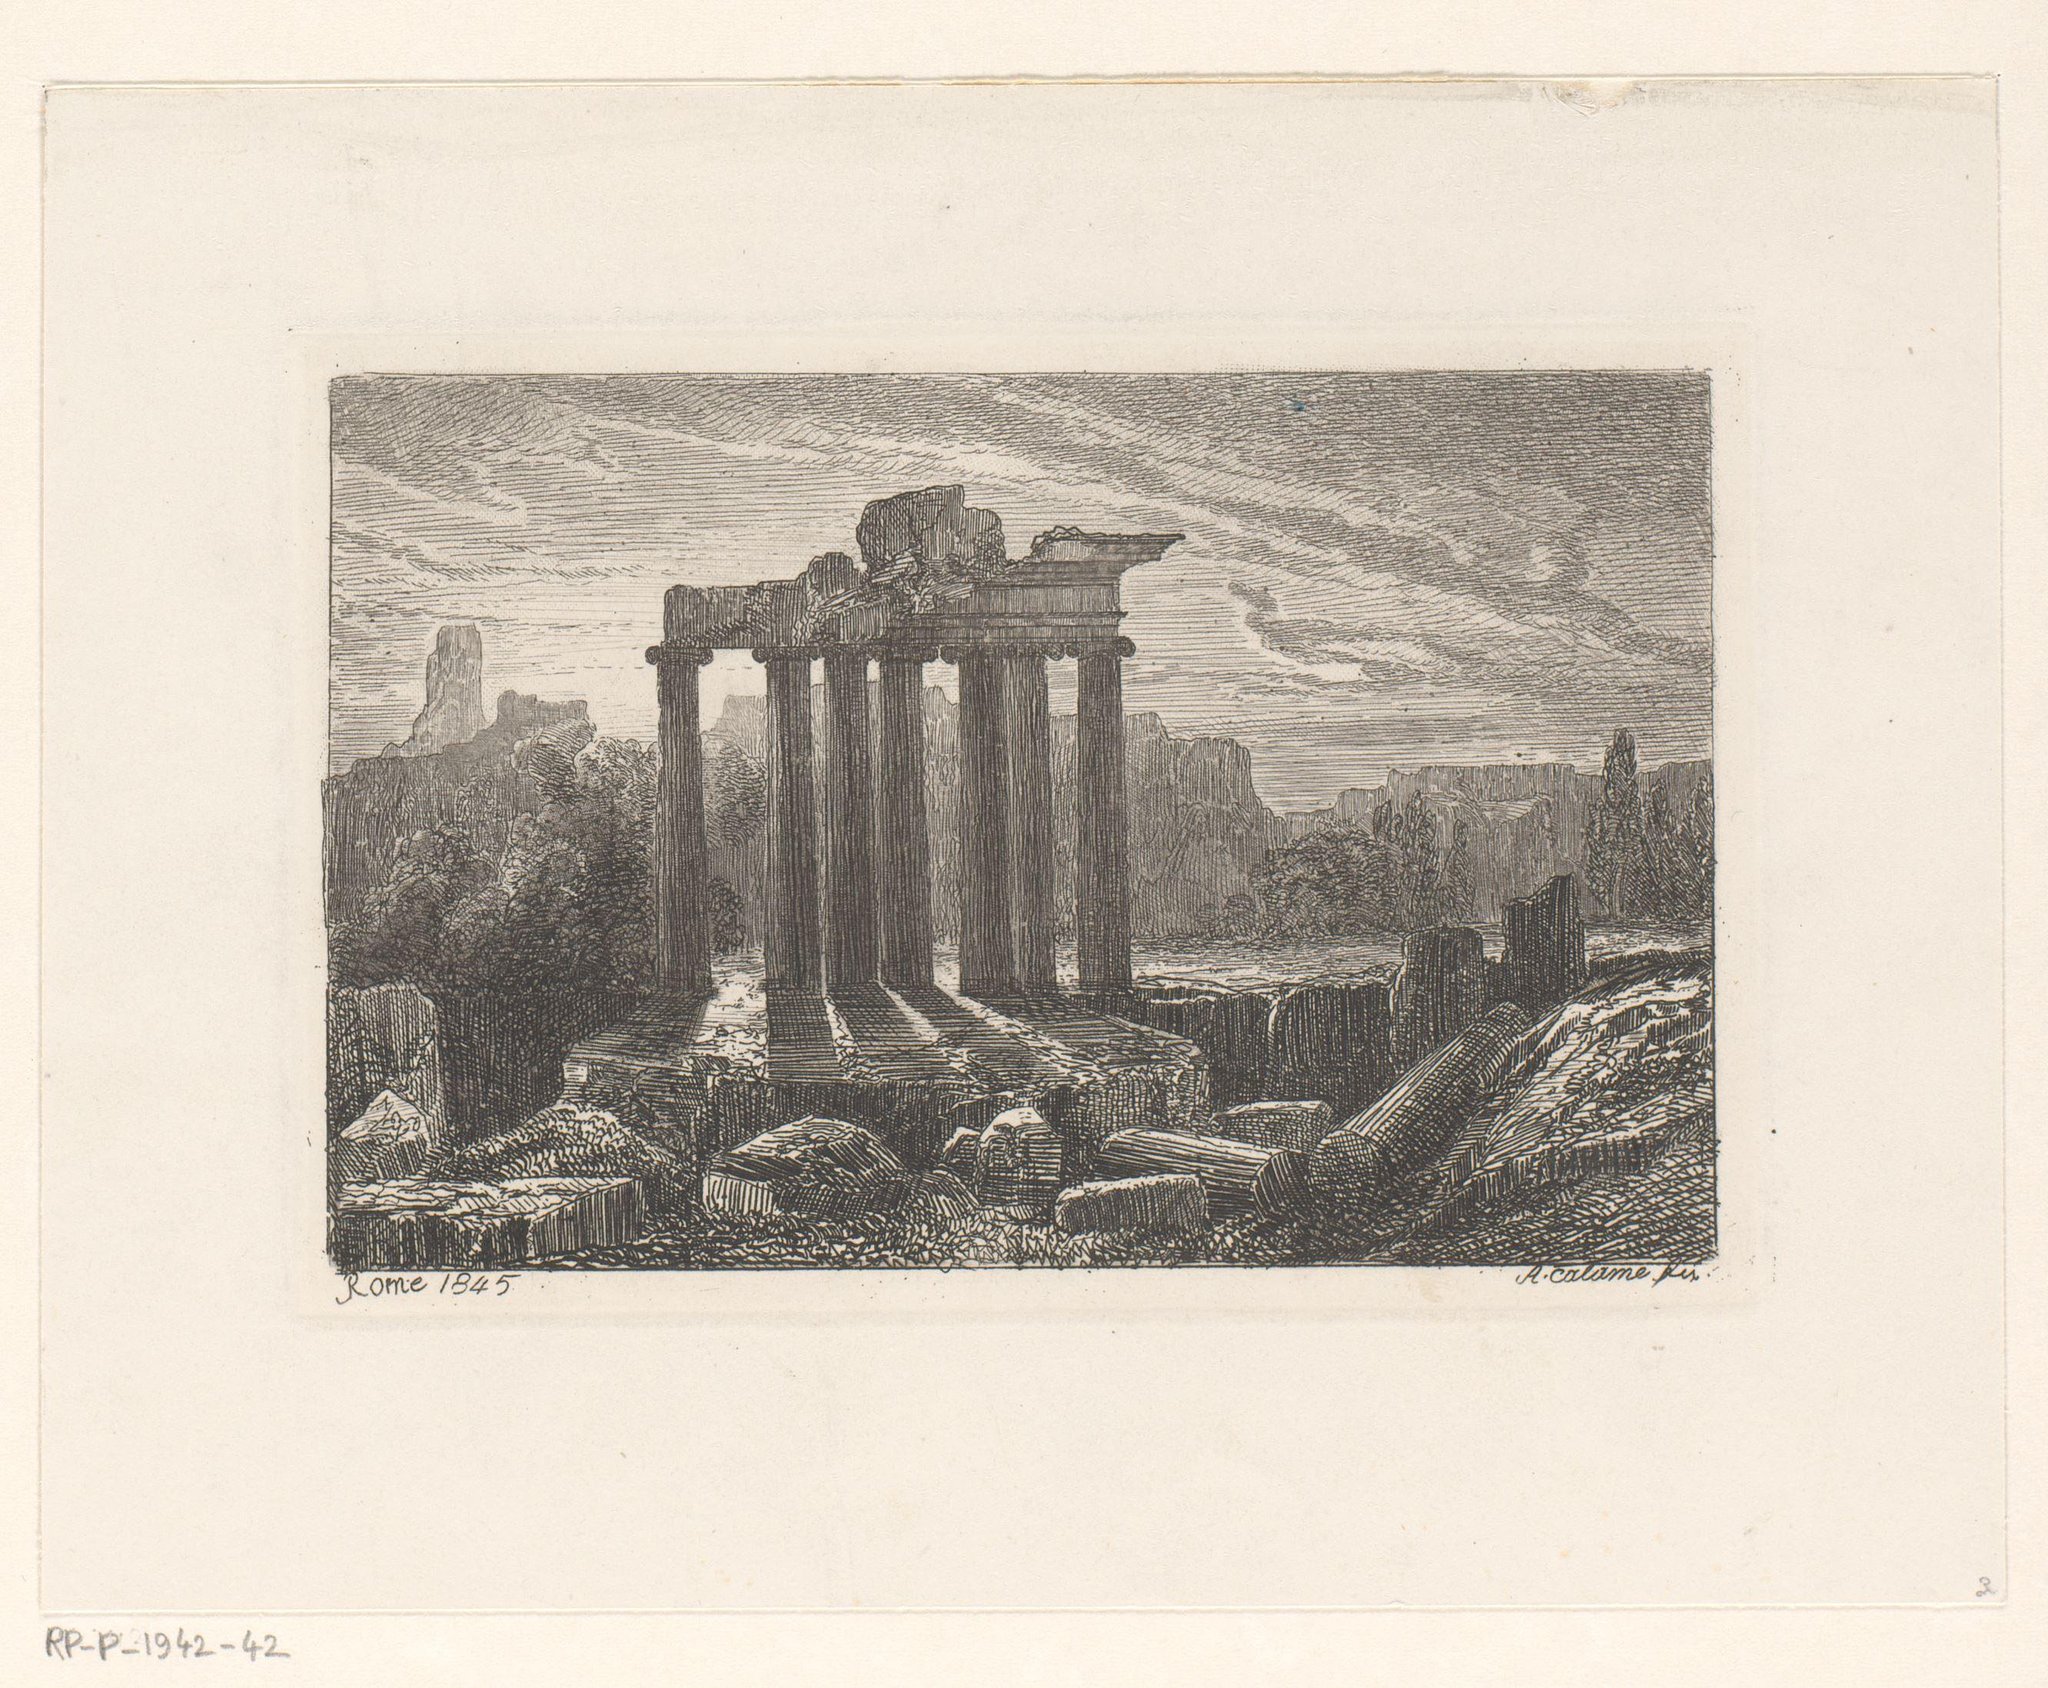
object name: print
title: Gezicht op een tempel in Rome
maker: alexandre calame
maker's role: draughtsman, painter, print maker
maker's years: 1810-1864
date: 1845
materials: paper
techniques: etching, roulette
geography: rome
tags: temple, shrine ~ roman religion, mountains, rome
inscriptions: collector's mark: Lugt 2760, collector's mark: Lugt 2228